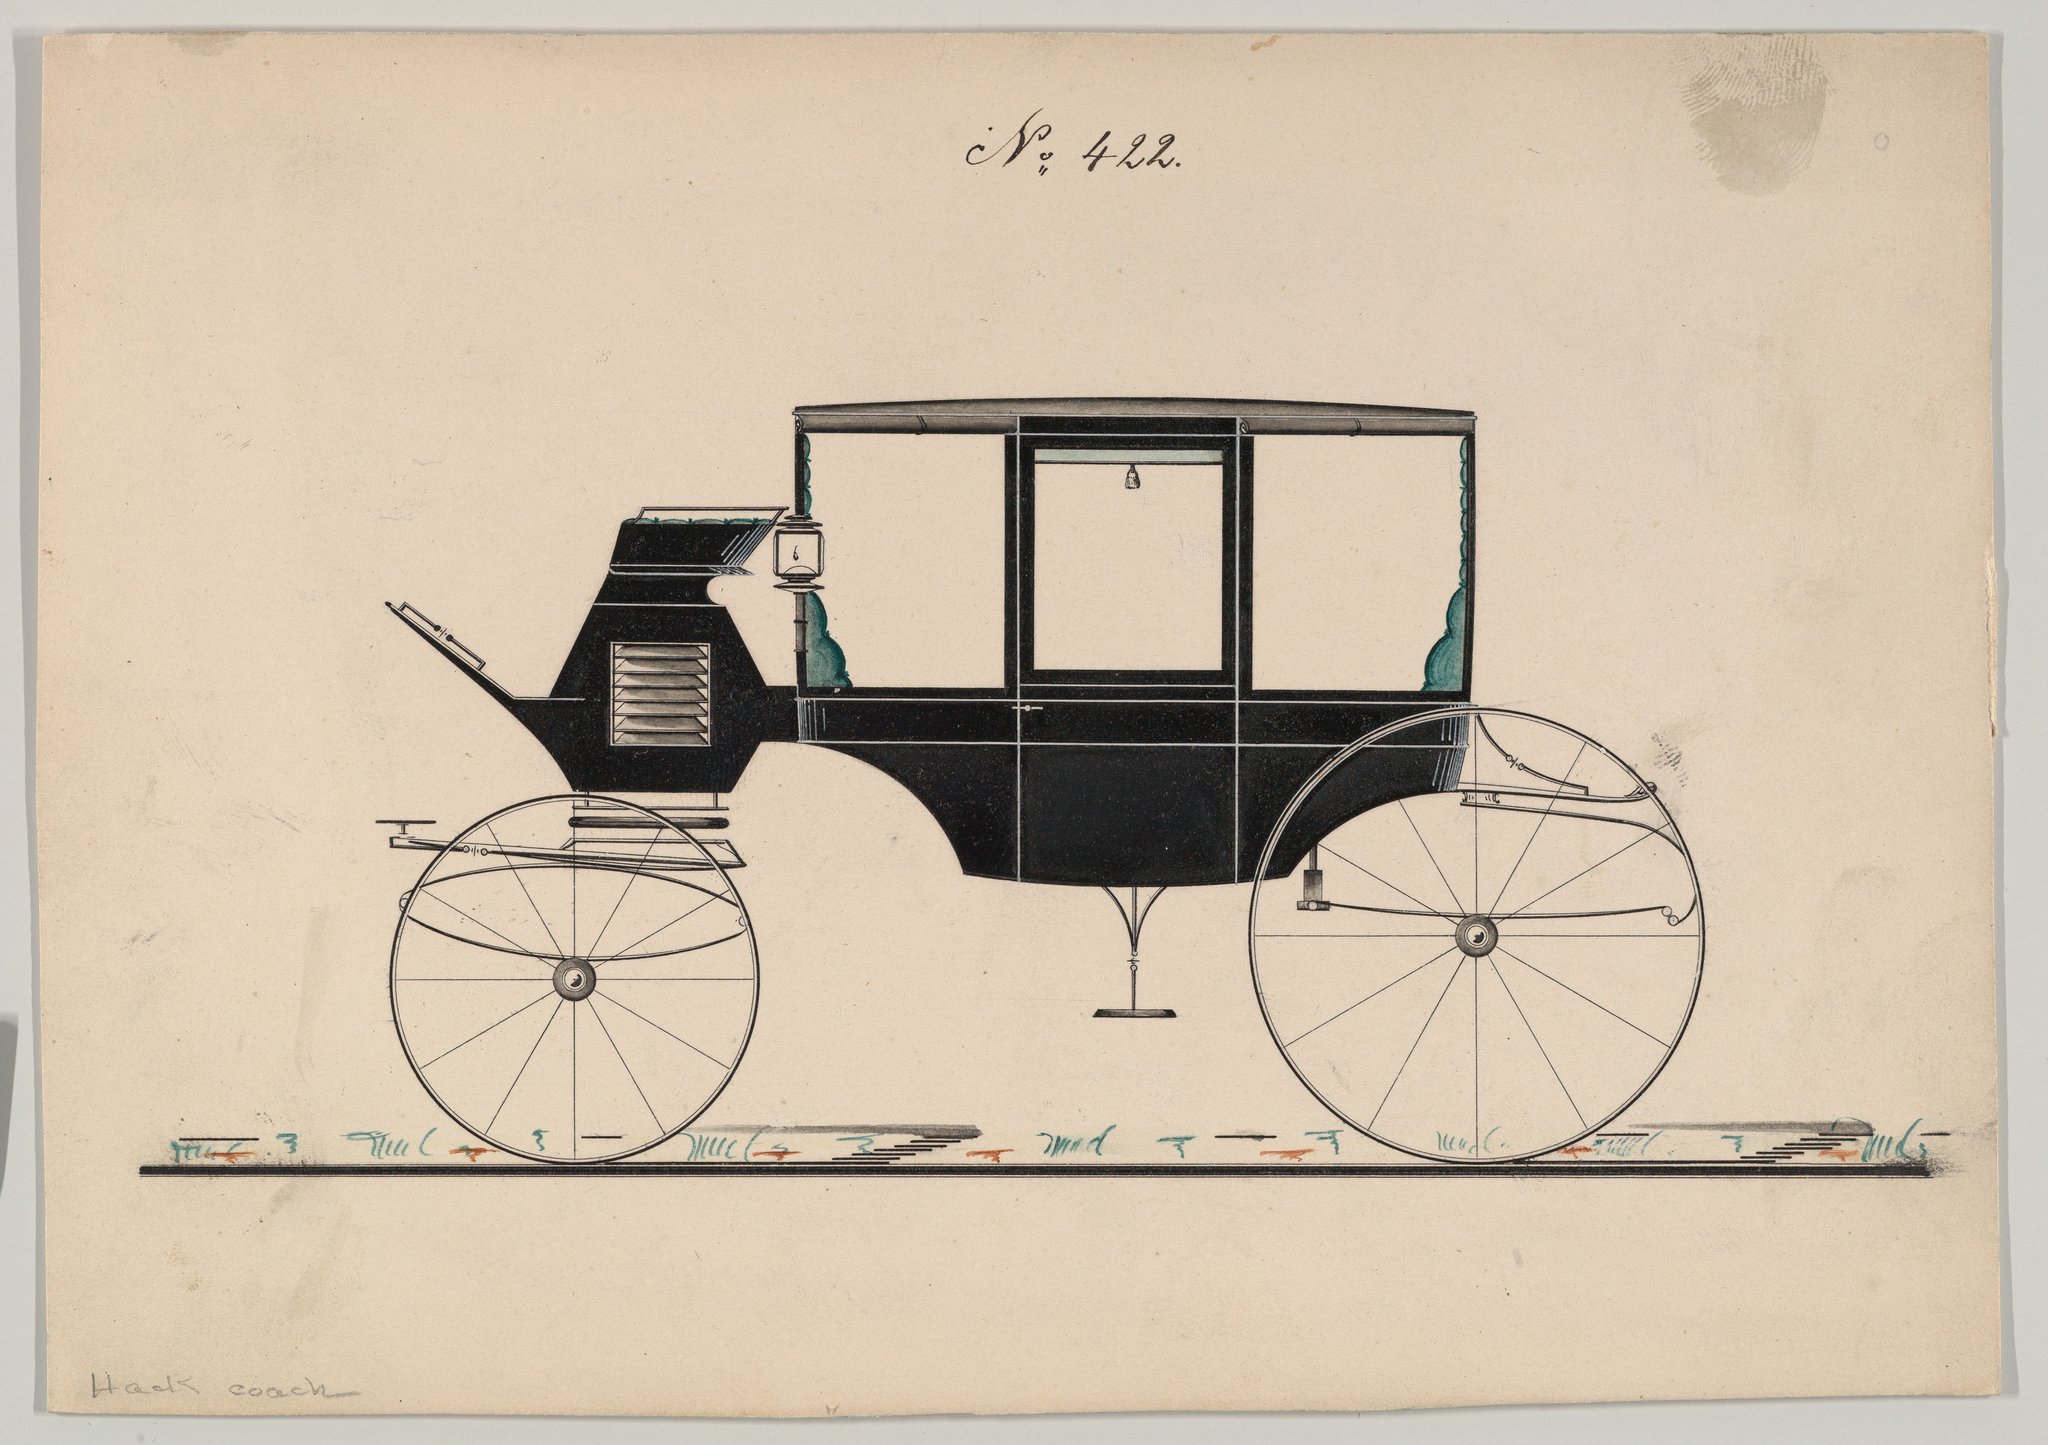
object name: drawing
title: Hack Coach #422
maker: brewster & co.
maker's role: manufacturer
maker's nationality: american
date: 1870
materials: ink, watercolor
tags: carriages